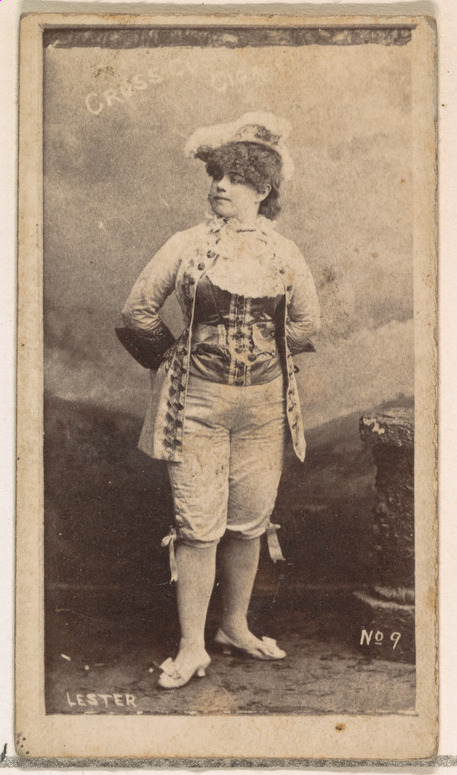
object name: print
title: Card Number 9, Lester, from the Actors and Actresses series (N145-1) issued by Duke Sons & Co. to promote Cross Cut Cigarettes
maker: w. duke, sons & co.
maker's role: publisher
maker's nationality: american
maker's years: 1870-1920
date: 1880-1889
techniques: albumen silver print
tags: portraits,women,actresses